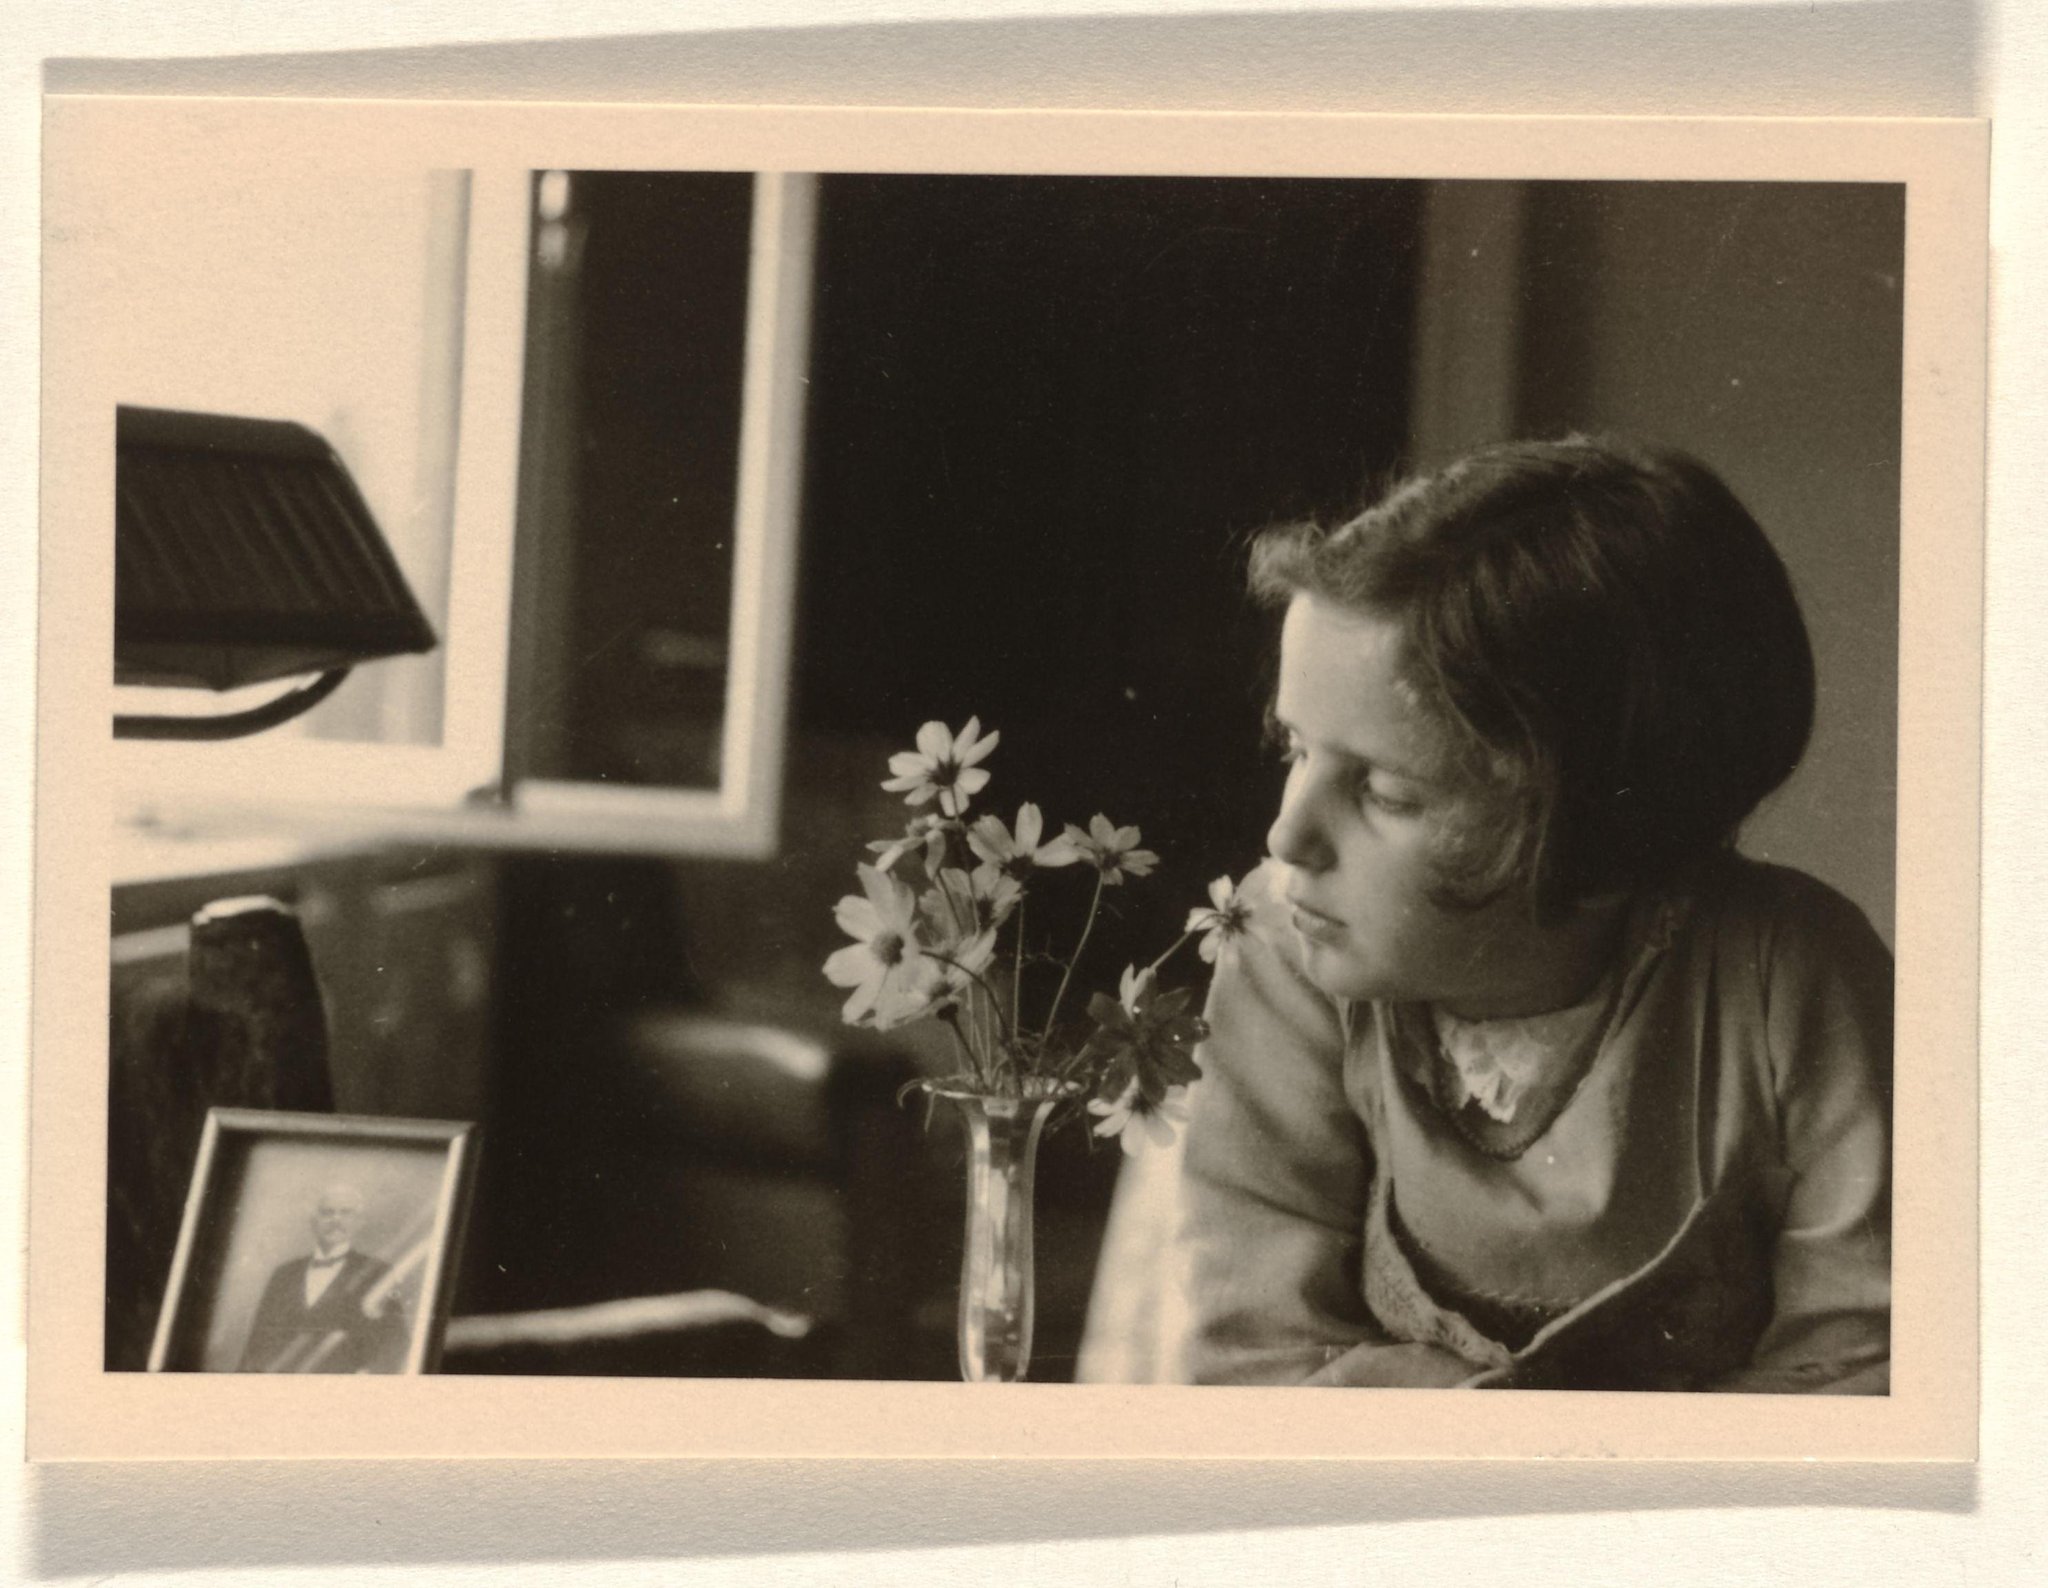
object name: photograph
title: Isabel Wachenheimer gezeten naast bloemen en kijkend naar een foto van haar grootvader Meir Wachenheimer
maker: Anonymous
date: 1936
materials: photographic support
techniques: gelatin silver print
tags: leiden, isabel wachenheimer-elon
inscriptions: date: ‘Juli 1936.’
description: Isabel Wachenheimer gezeten naast bloemen en kijkend naar een foto van haar grootvader Meir Wachenheimer.